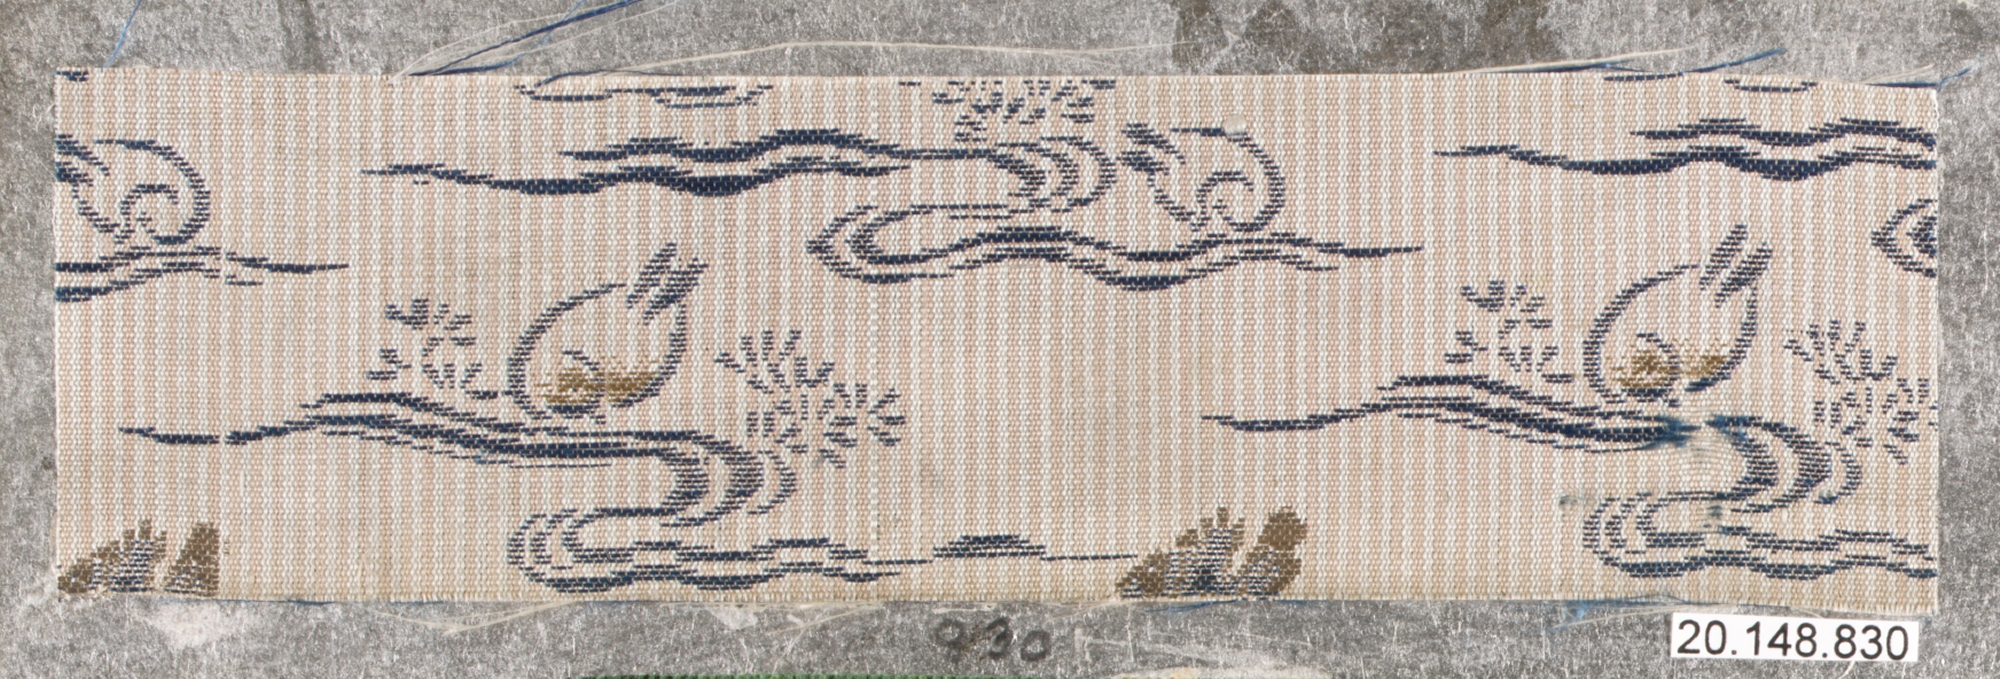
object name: piece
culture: japanese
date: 1701-1800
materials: silk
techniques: compound weave